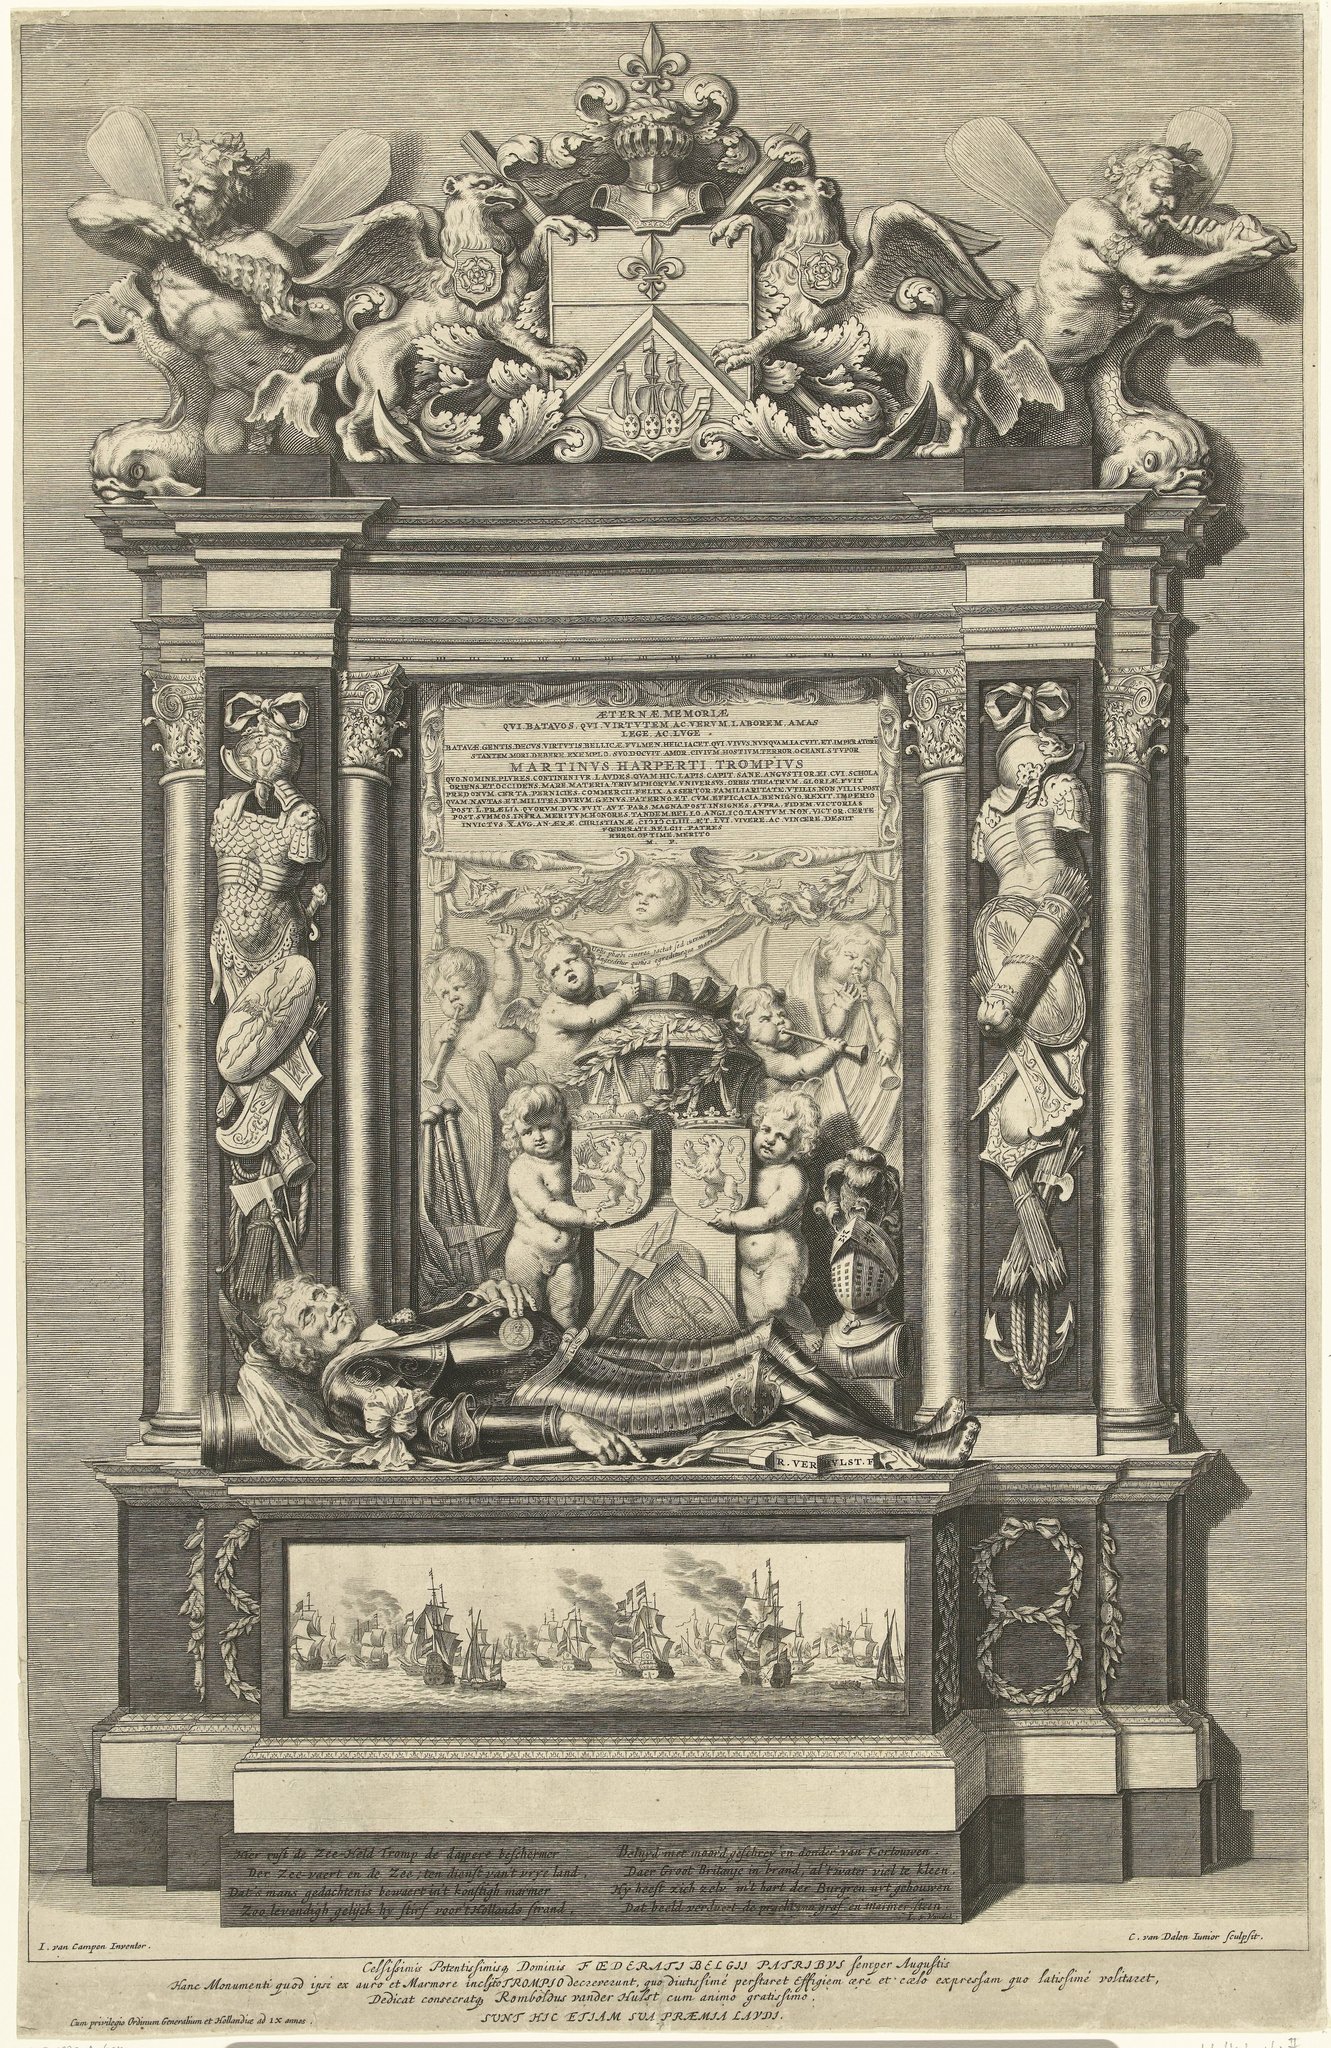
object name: print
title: Graftombe van admiraal Maarten Harpertsz. Tromp in Oude Kerk te Delft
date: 1656-1664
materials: paper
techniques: engraving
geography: amsterdam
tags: brielle, maarten harpertszoon tromp, grave-building, monumental tomb, battle of scheveningen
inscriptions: collector's mark: Lugt 2228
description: Graftombe van admiraal Maarten Harpertsz. Tromp in Oude Kerk te Delft. Beeld van de gesneuvelde admiraal in harnas liggend op tombe met zeeslag bij Terheide op fries. Tegen de wand marmeren reliëf met putti met wapenschilden en wapenrusting geflankeerd door zuilen en militaria. Bovenop lijst bekroond met wapendschild vastgehouden door griffioenen en geflankeerd door tritons of meermannen. Op de basis van het praalgraf een vers in acht regels van Joost van den Vondel.